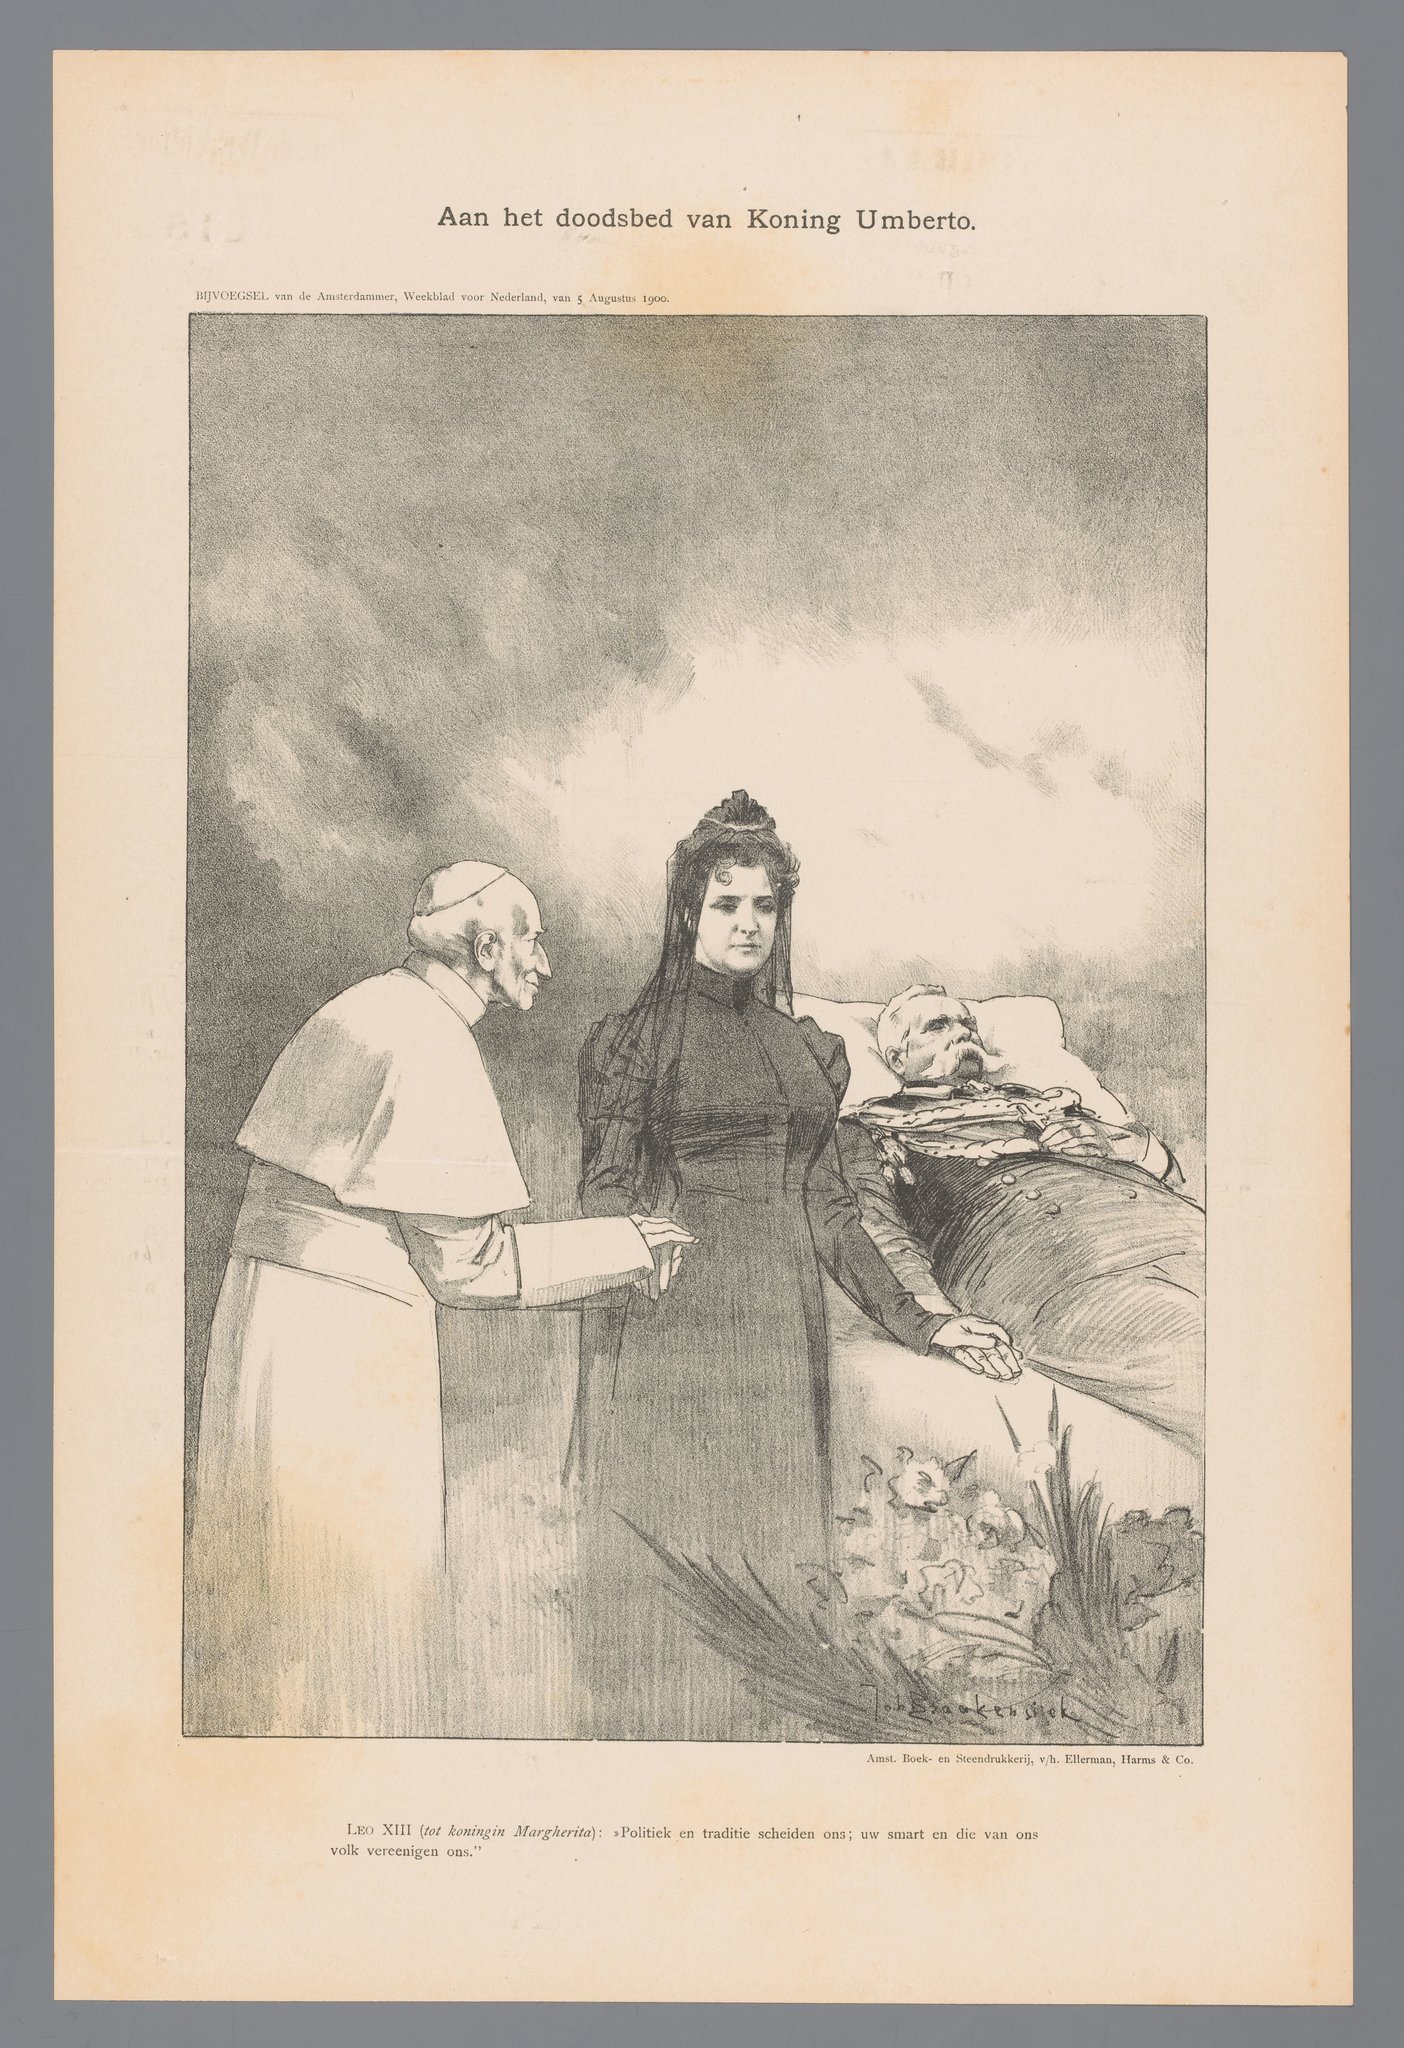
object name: print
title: Aan het doodsbed van Koning Umberto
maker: johan braakensiek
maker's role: draughtsman, print maker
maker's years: 1858-1940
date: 1900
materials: paper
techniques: lithograph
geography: amsterdam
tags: rome, leo xiii, deathbed, historical persons, ruler, sovereign, pope, politics, italy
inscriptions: date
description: Prent uit het bijvoegsel van: De Amsterdammer. Weekblad voor Nederland, 5 augustus 1900.